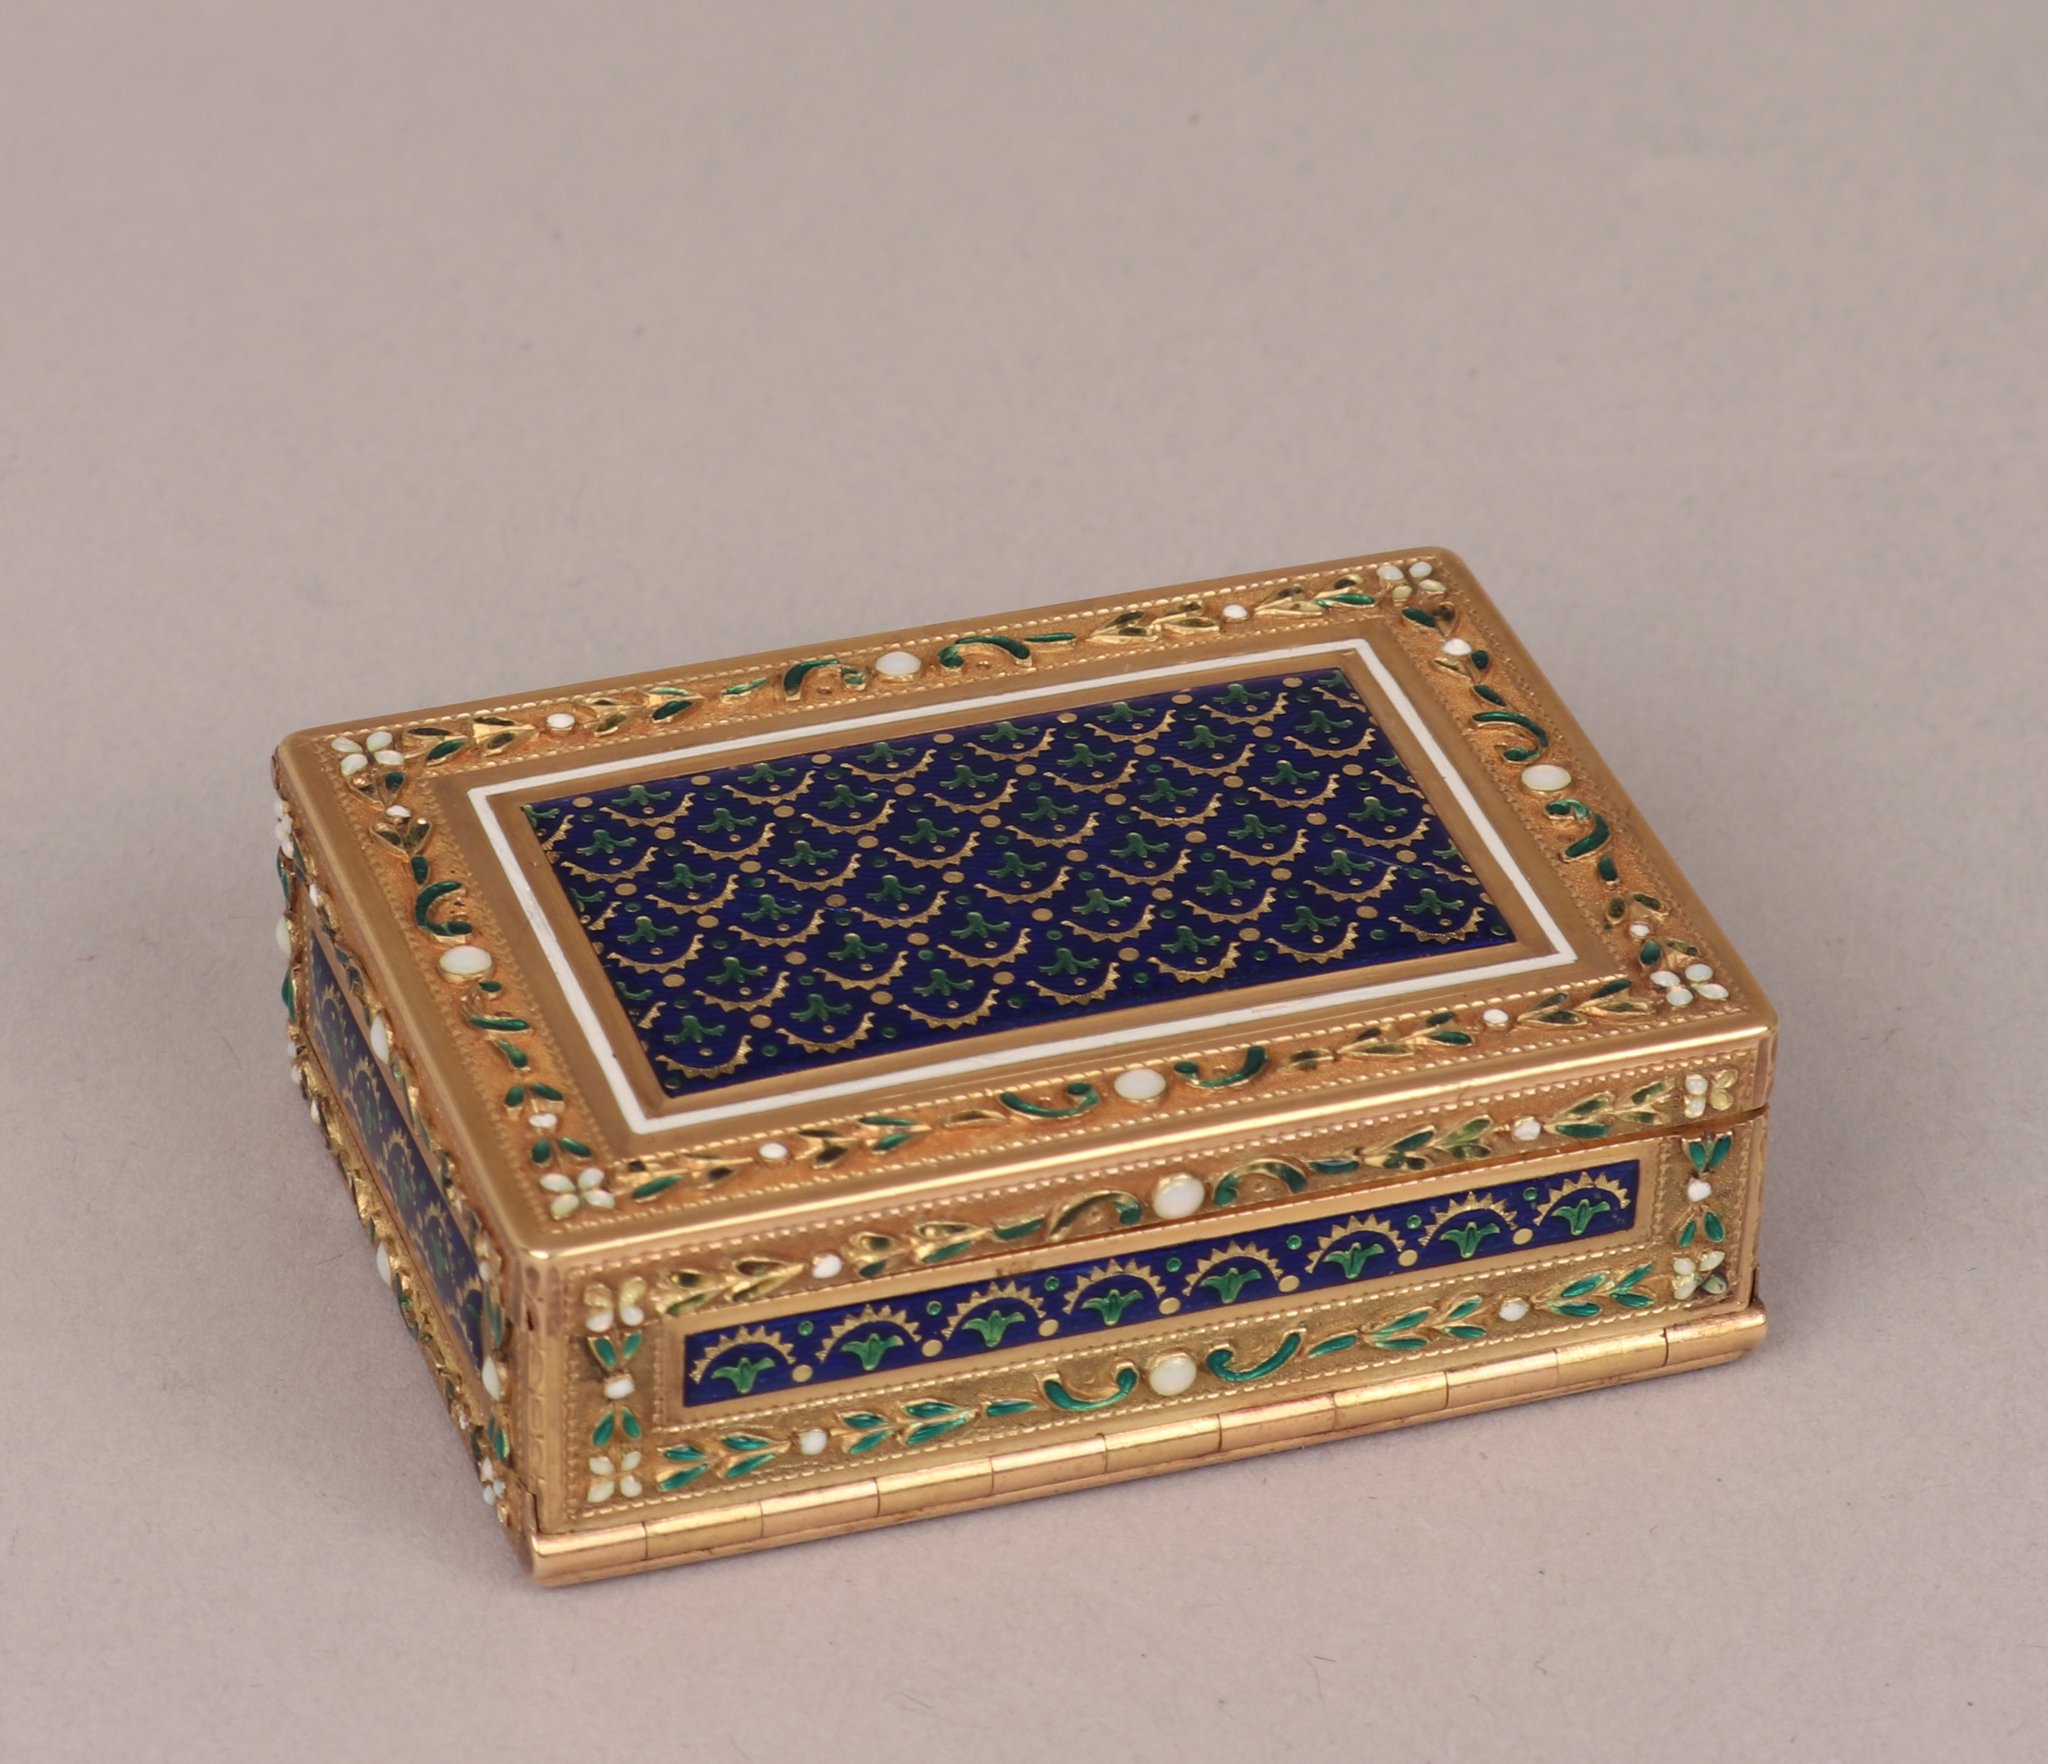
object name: patch box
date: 1784-1789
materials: enamel, gold, hair